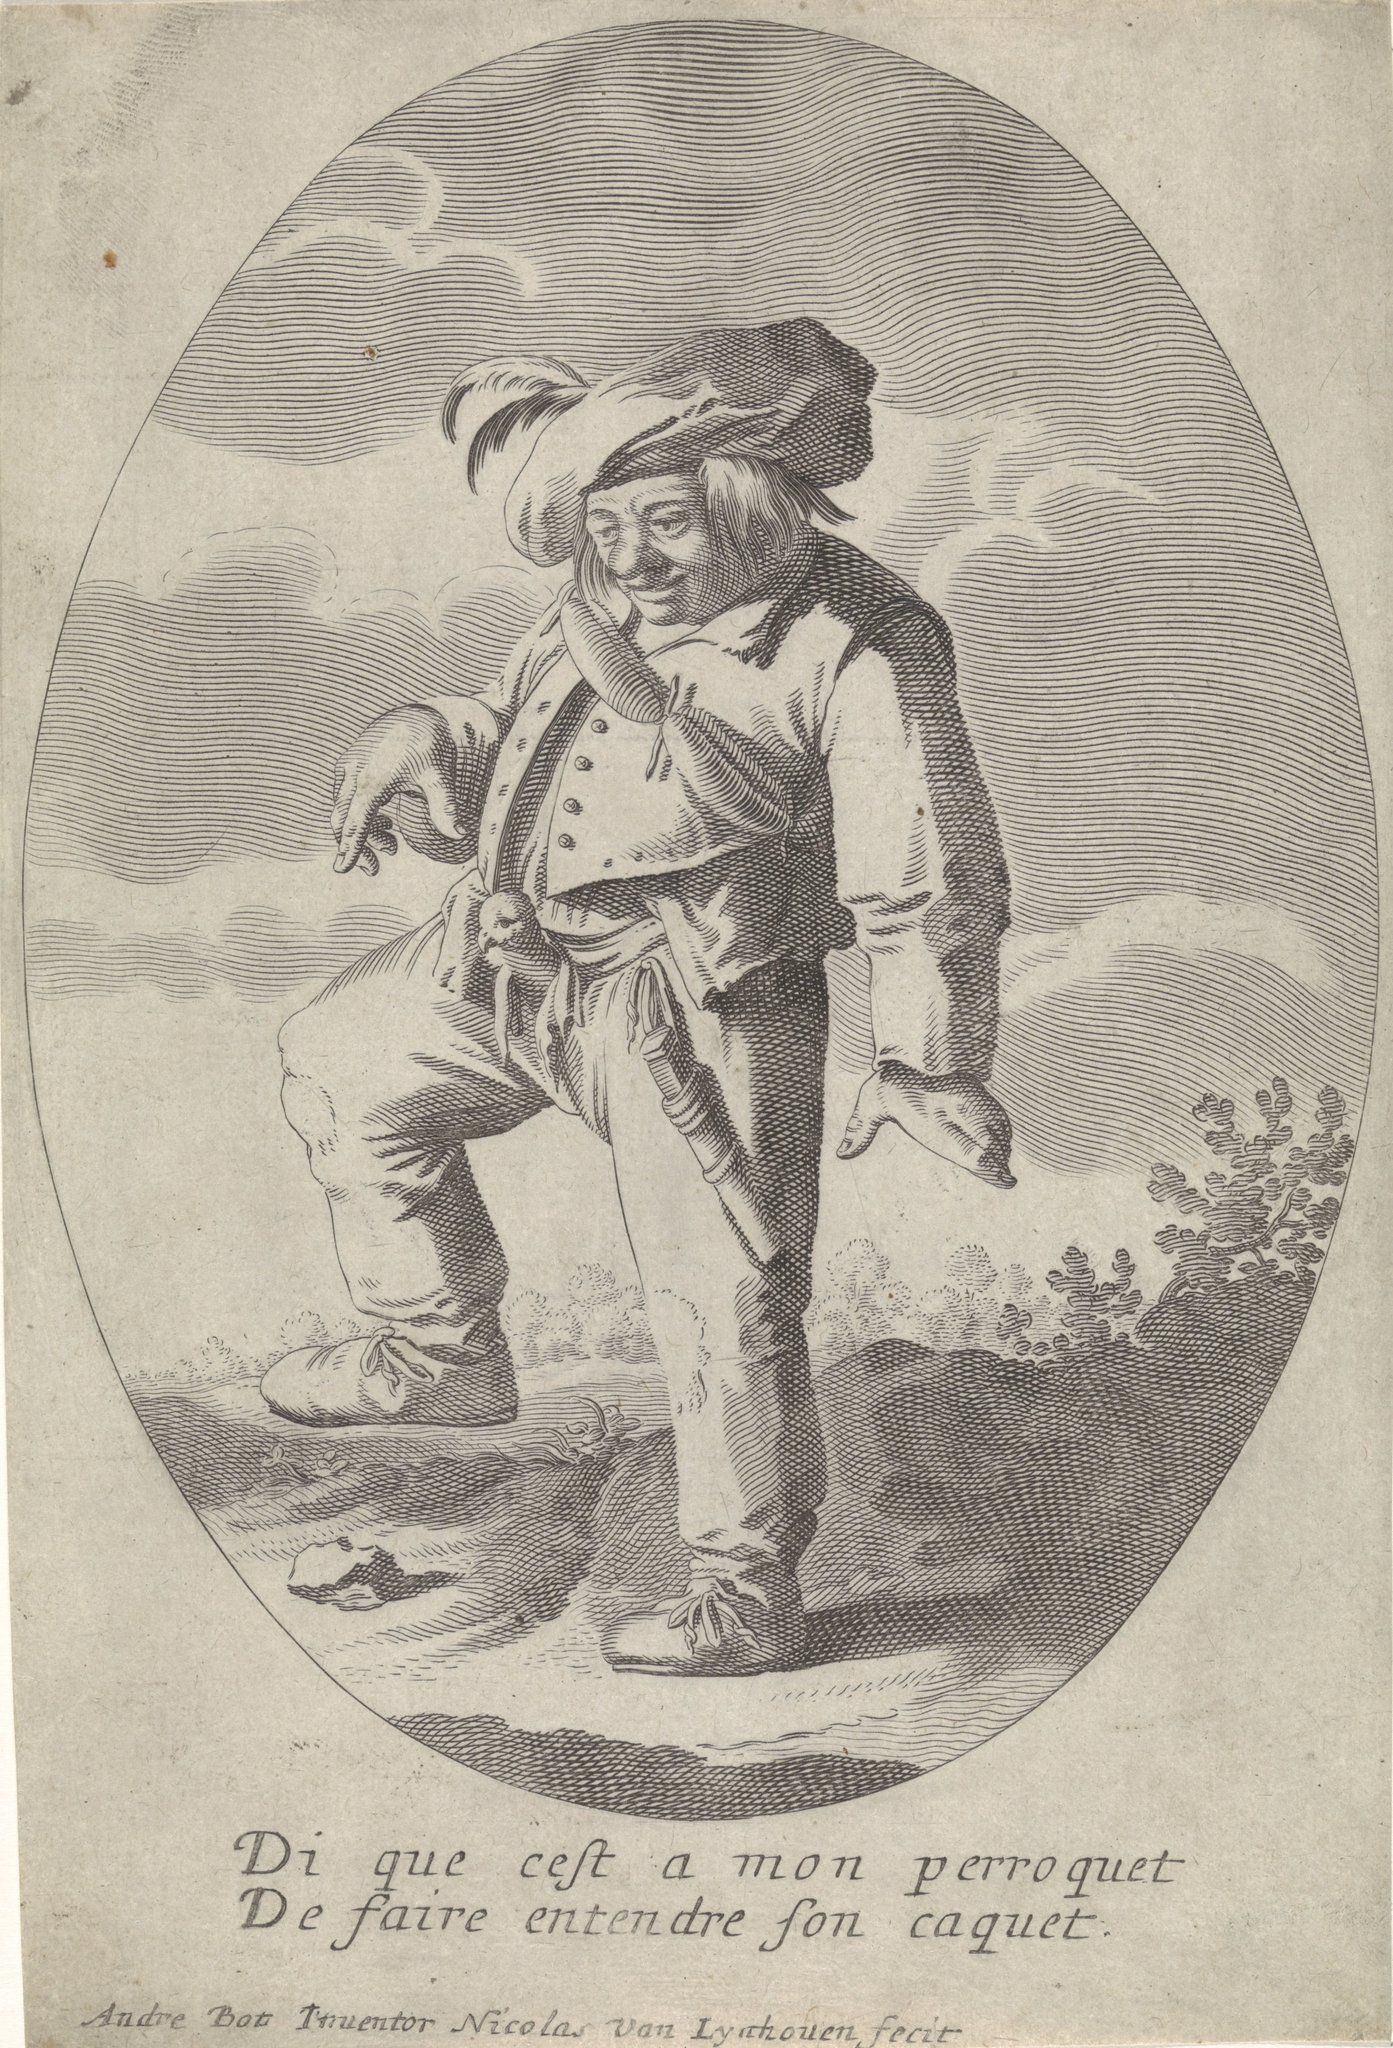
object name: print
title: Dansende boer, omhangen met een rij worsten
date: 1622-1668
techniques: engraving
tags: scabrous scenes, pornography (+ variant), gesture-language, farmers, sausage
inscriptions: collector's mark: Lugt 2228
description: Een dansende boer in een landschap. Om zijn lijf hangt een rij worsten, uit zijn gulp steekt een vogelkop. Onder de ovale voorstelling een tweeregelig Frans vers.